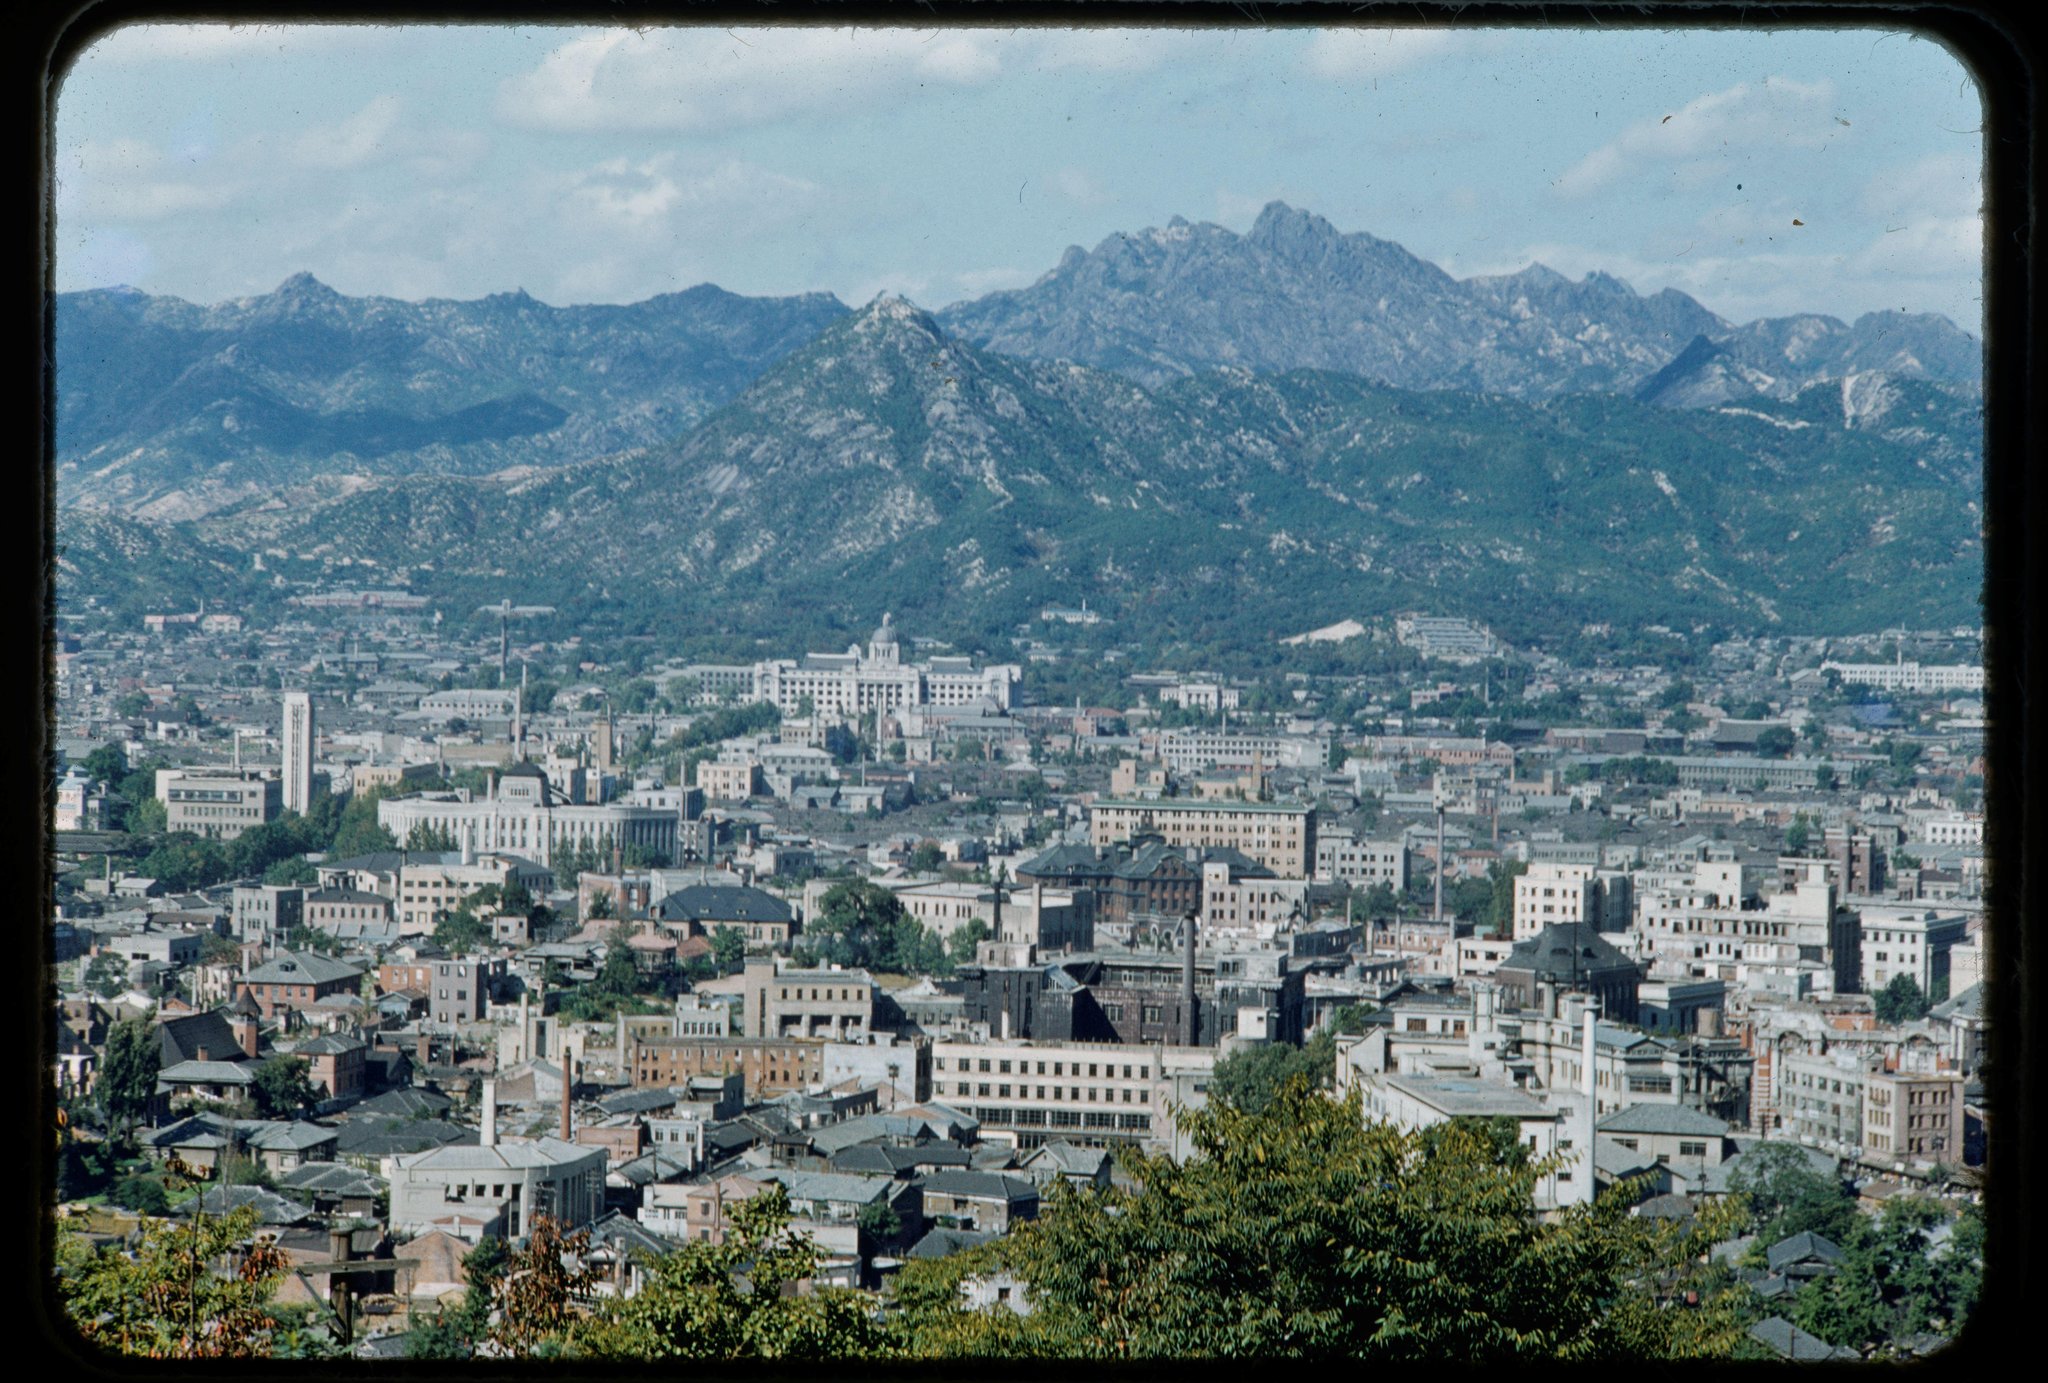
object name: color slide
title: Seoul, oktober 1952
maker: david ketel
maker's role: diplomaat, sinoloog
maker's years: 1913-2008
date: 1910-1952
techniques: slide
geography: korea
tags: united nations